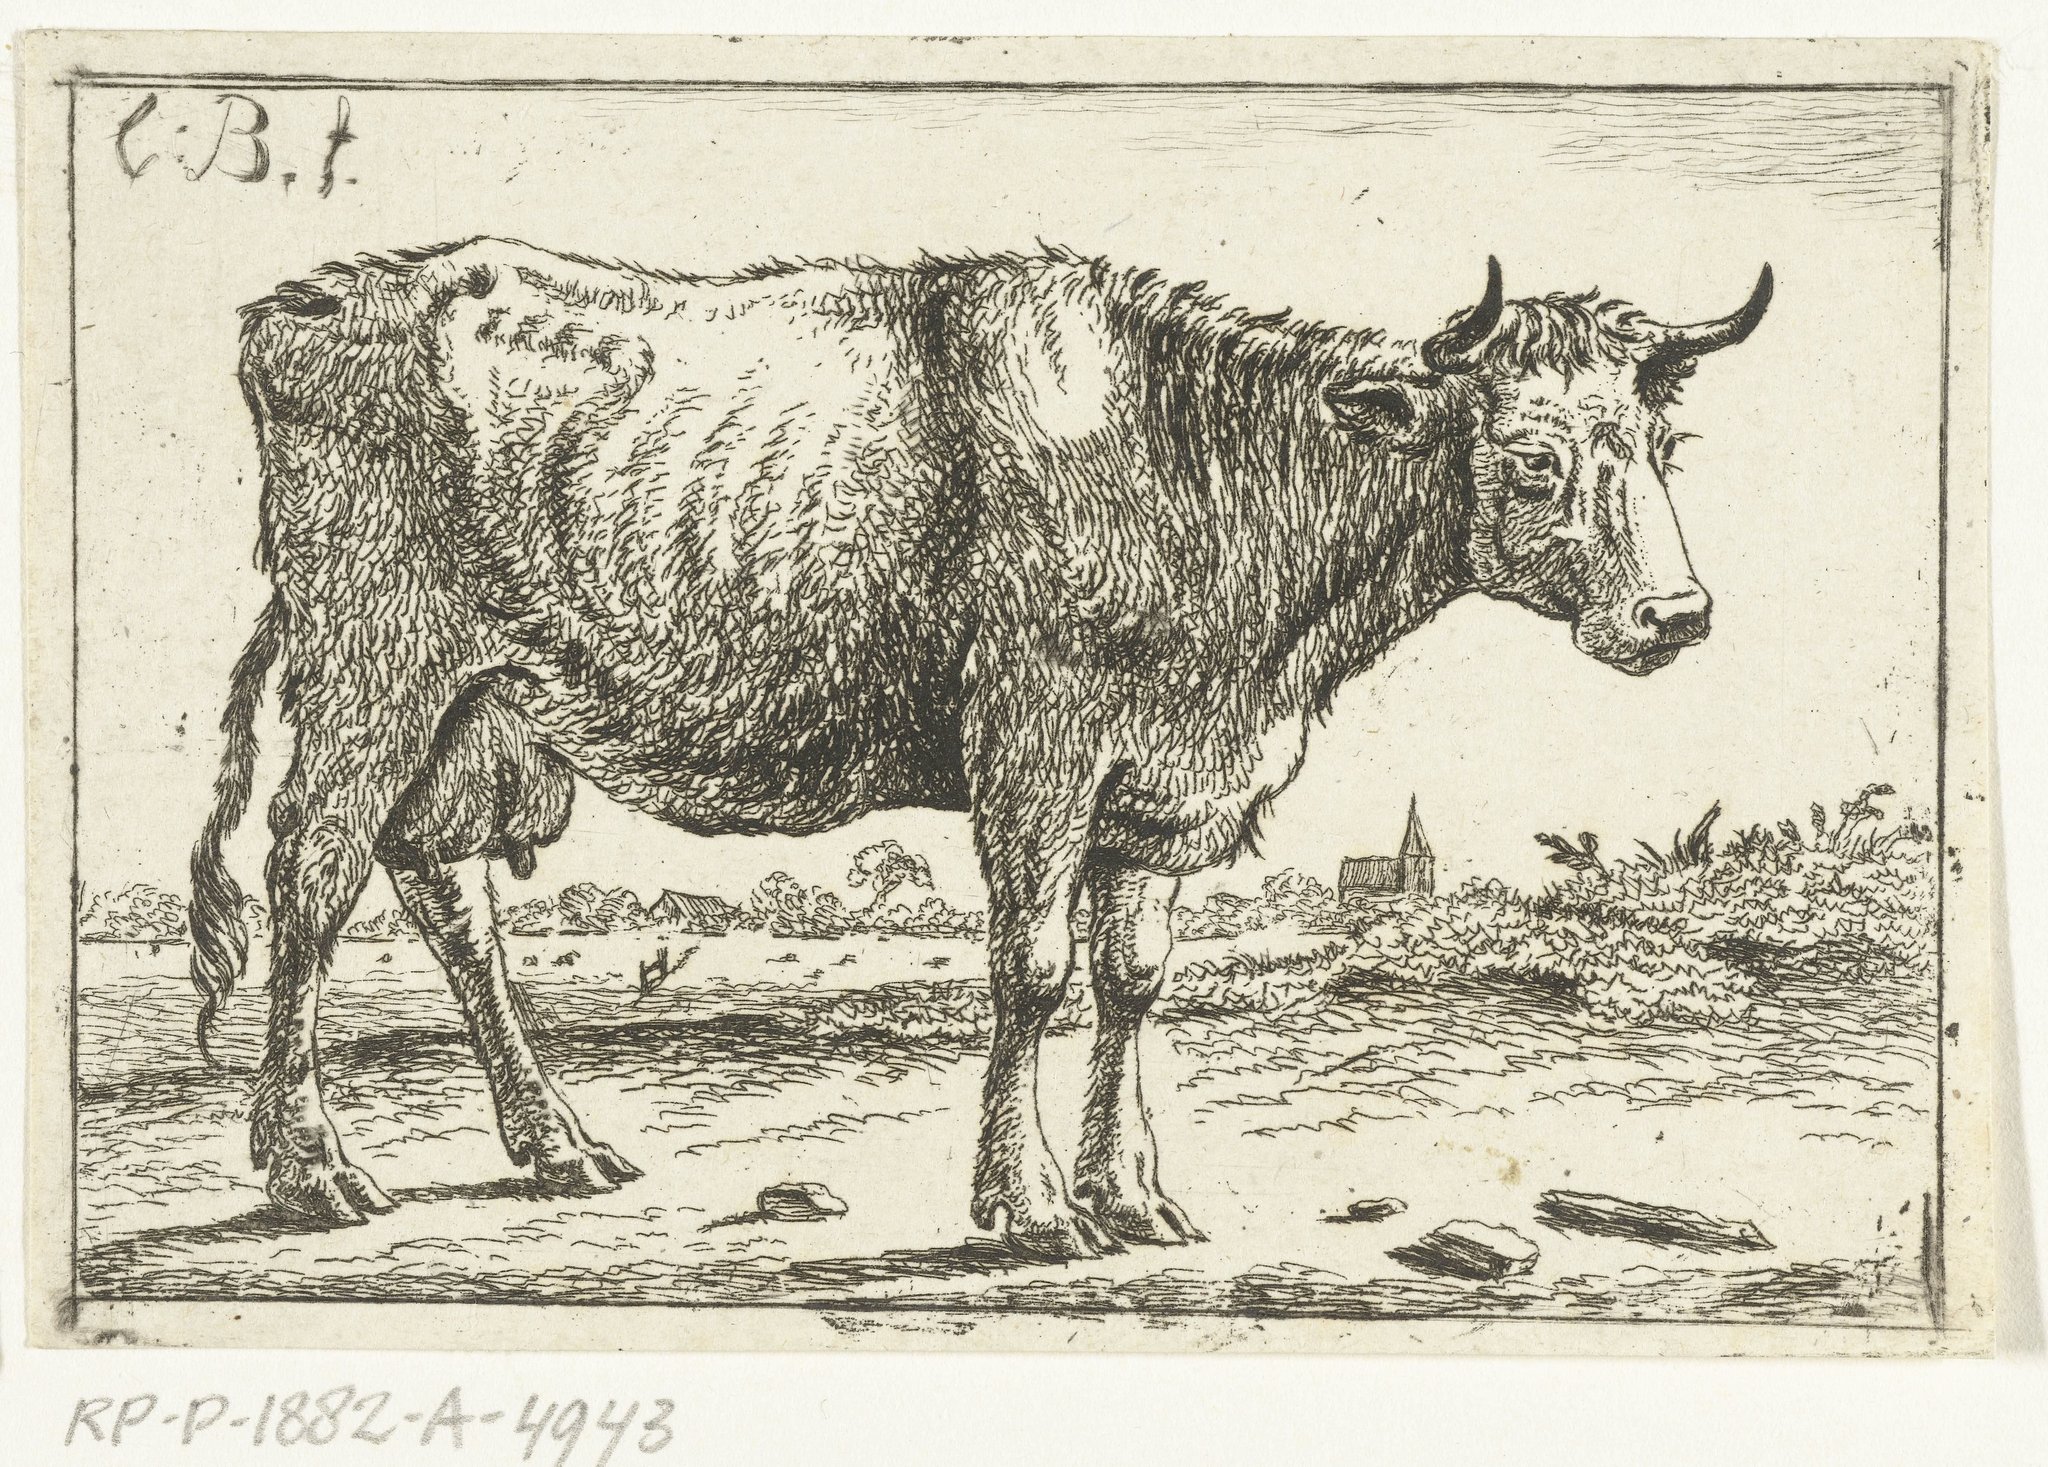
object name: print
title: Landschap met koe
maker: cornelis bisschop (1762-1829)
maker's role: print maker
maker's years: 1762-1829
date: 1777-1829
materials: paper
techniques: etching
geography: netherlands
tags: cow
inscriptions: collector's mark: Lugt 2228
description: Prent mogelijk uit serie met onbekend aantal prenten van koeien.